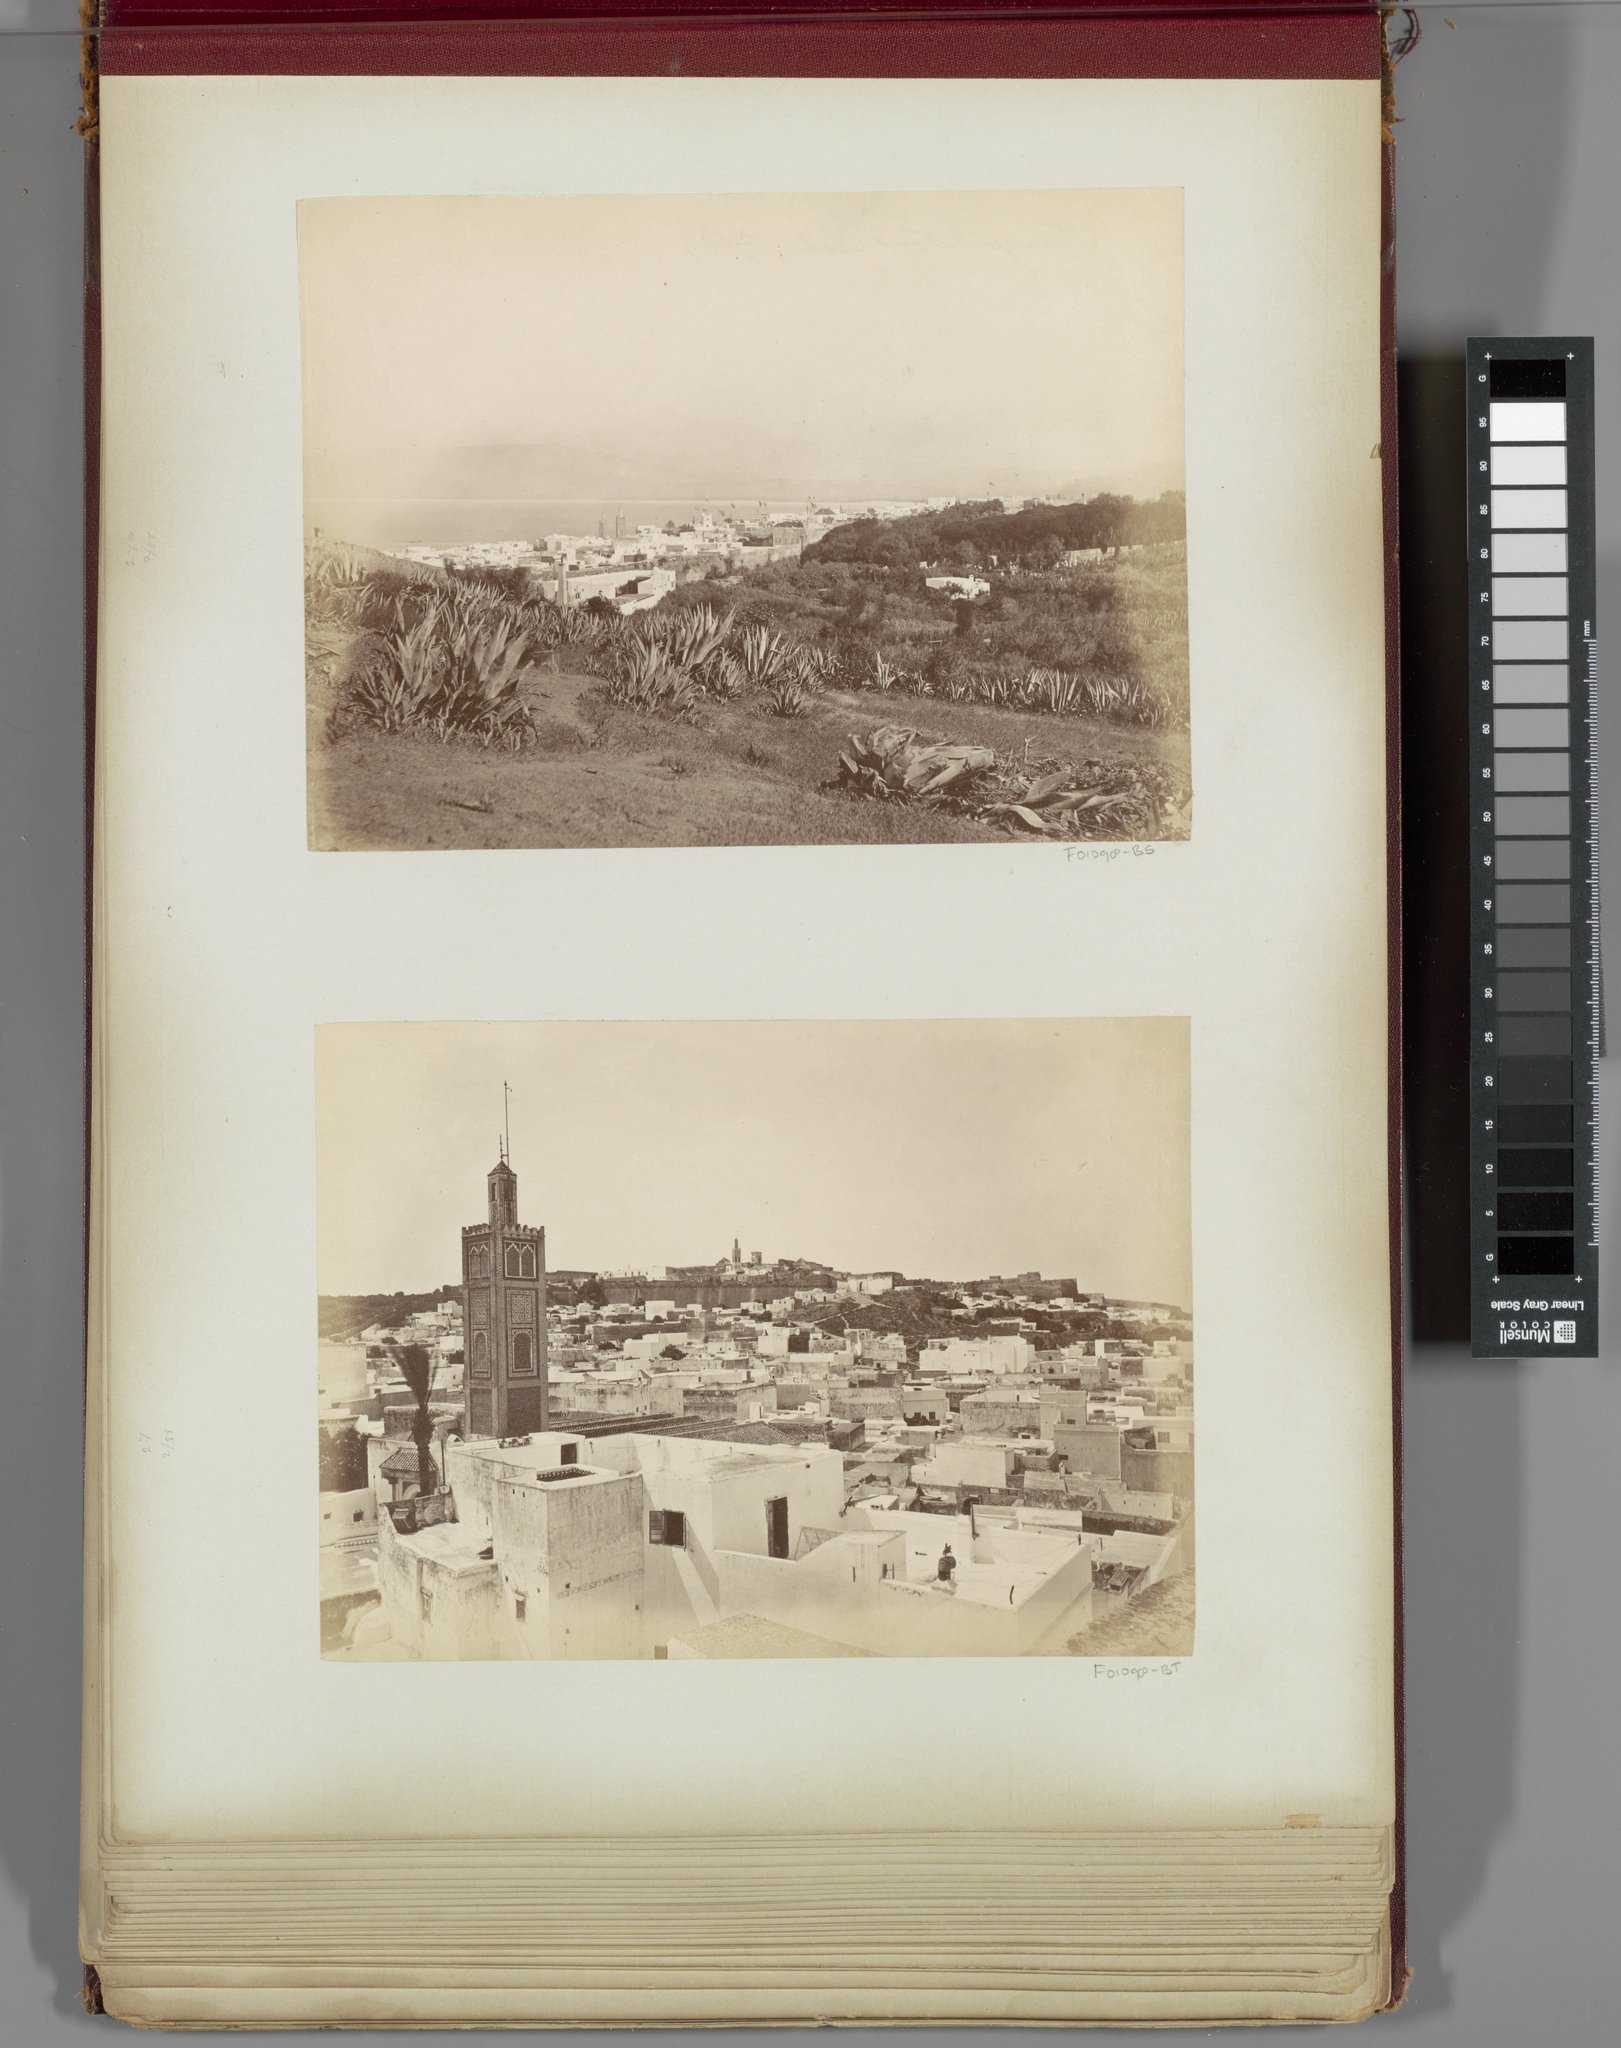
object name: photograph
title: Gezicht op een Marokkaanse stad met torens en dakterrassen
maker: antonio cavilla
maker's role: fotograaf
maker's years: 1867-1908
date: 1880-1910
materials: cardboard, paper, photographic support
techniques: albumen print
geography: north africa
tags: terrace, temple, shrine ~ islam, mohammedanism, prospect of city, town panorama, silhouette of city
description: Onderdeel van Reisalbum met foto's van bezienswaardigheden in Spanje en Marokko.